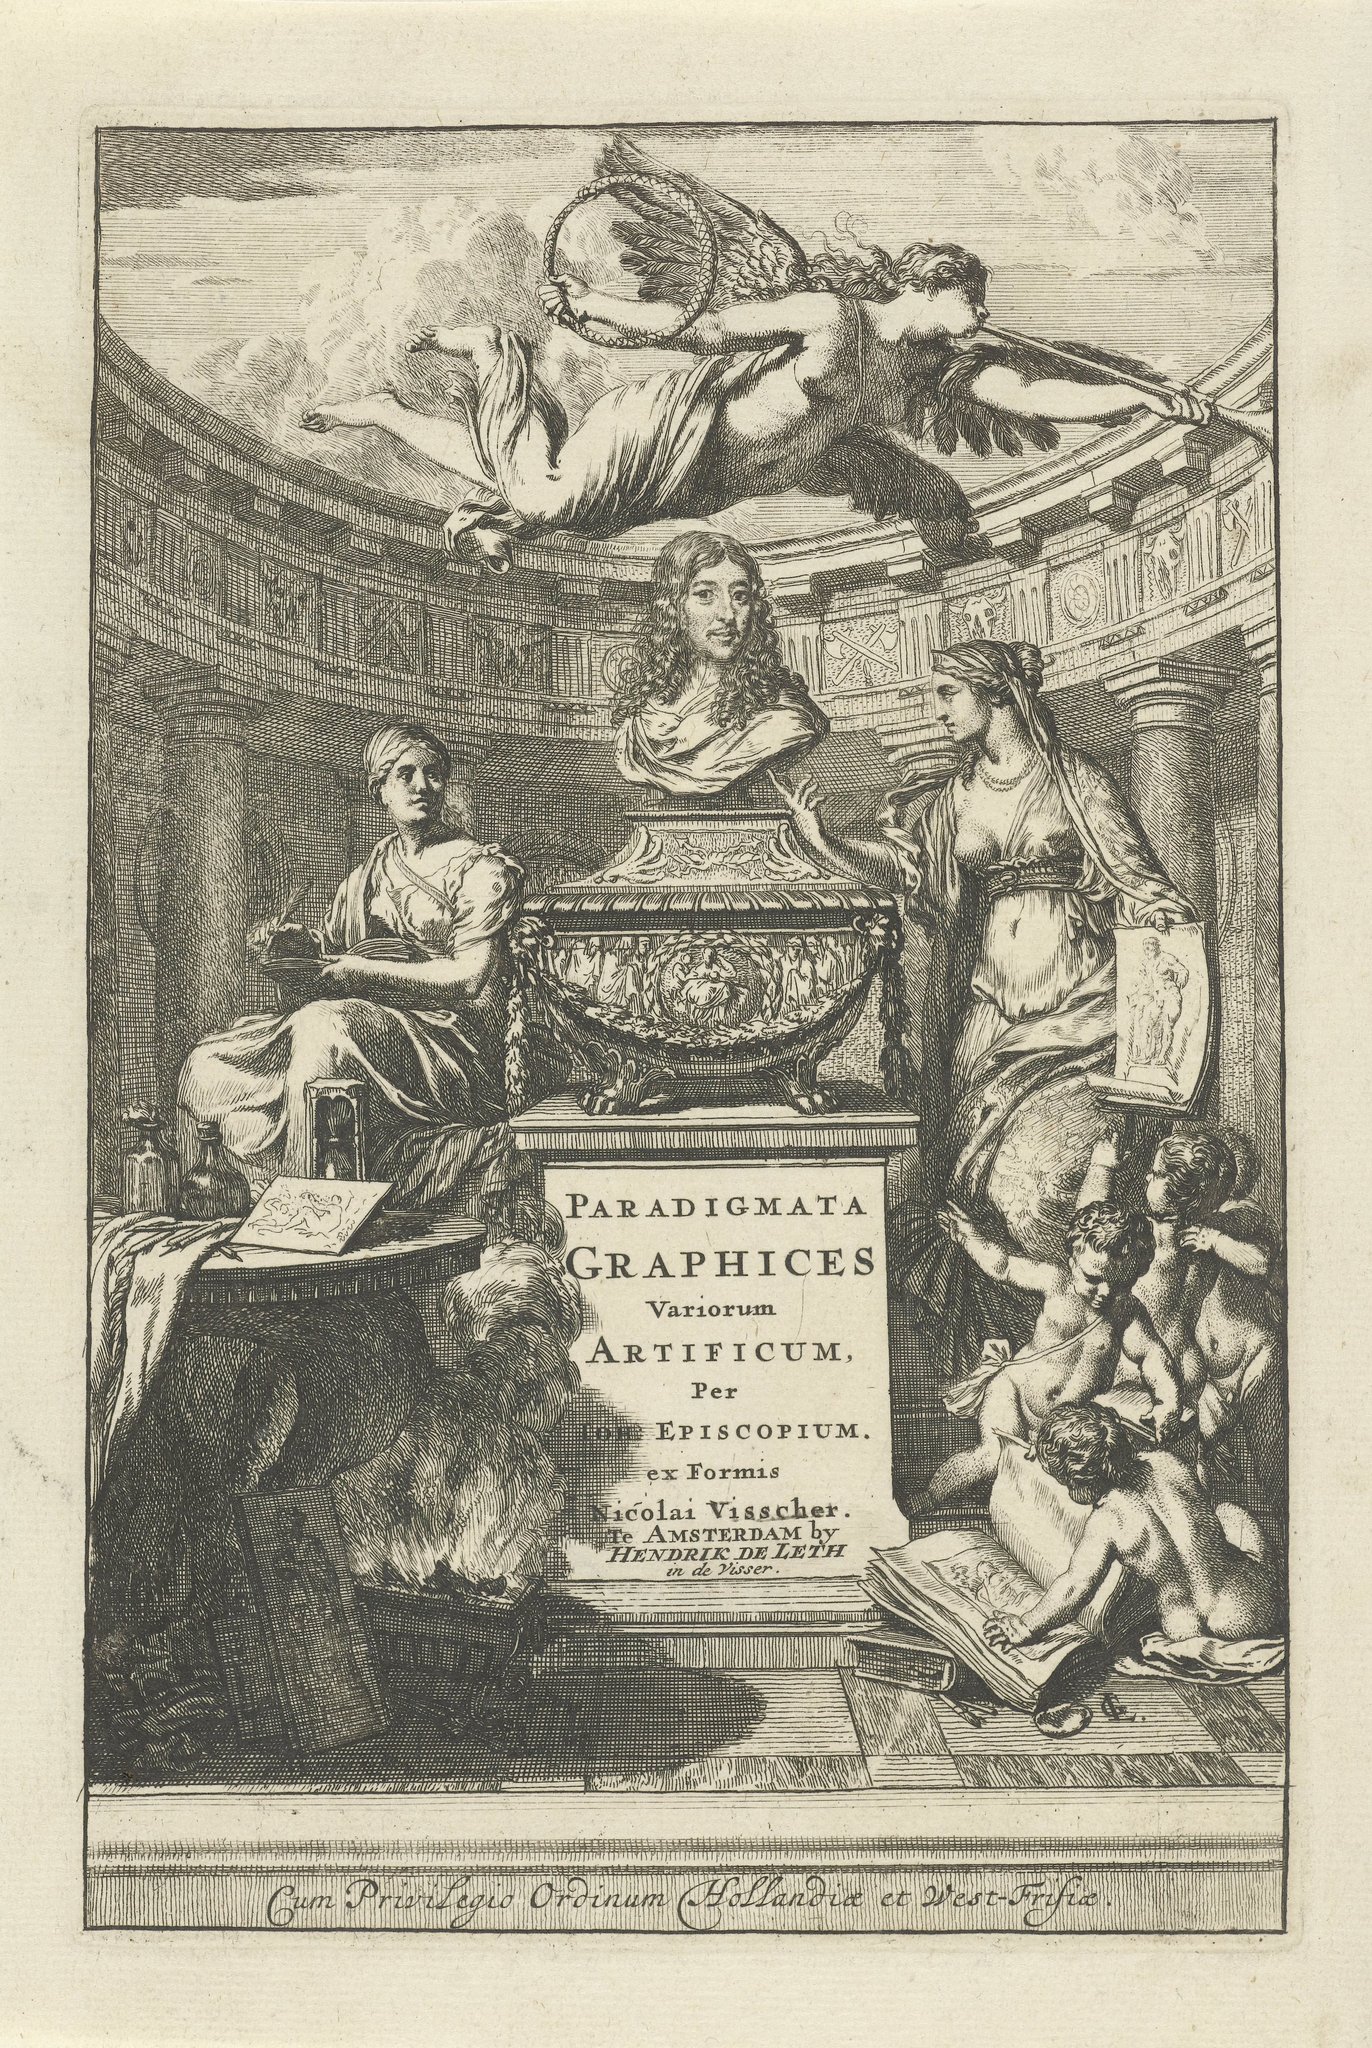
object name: titelblad, titelpagina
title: Titelpagina voor: J. de Bisschop, Paradigmata graphices variorum artificum, 17XX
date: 1670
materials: paper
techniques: etching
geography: amsterdam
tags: amsterdam, the hague, print maker, draughtsman, jan de bisschop, 'historia'; 'historia' (ripa), sculpture, fame; 'fama', 'fama buona', 'fama chiara' (ripa), cupids: 'amores', 'amoretti', 'putti', symbolic representations, allegories and emblems ~ drawing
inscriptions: collector's mark: Lugt 2228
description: Het gebeeldhouwde borstbeeld van tekenaar en prentmaker Jan de Bisschop staat op een antieke sarcofaag, hierboven vliegt de bazuin blazende Faam met het eeuwigheidssymbool (een slang die zich in eigen staart bijt). Links van het borstbeeld zit de personificatie van geschiedenis (Historia) met een schrijfveer en een opengeslagen boek in haar handen. Rechts houdt de gepersonifieerde tekenkunst een tekening vast, aan haar voeten bestuderen putti een boek.